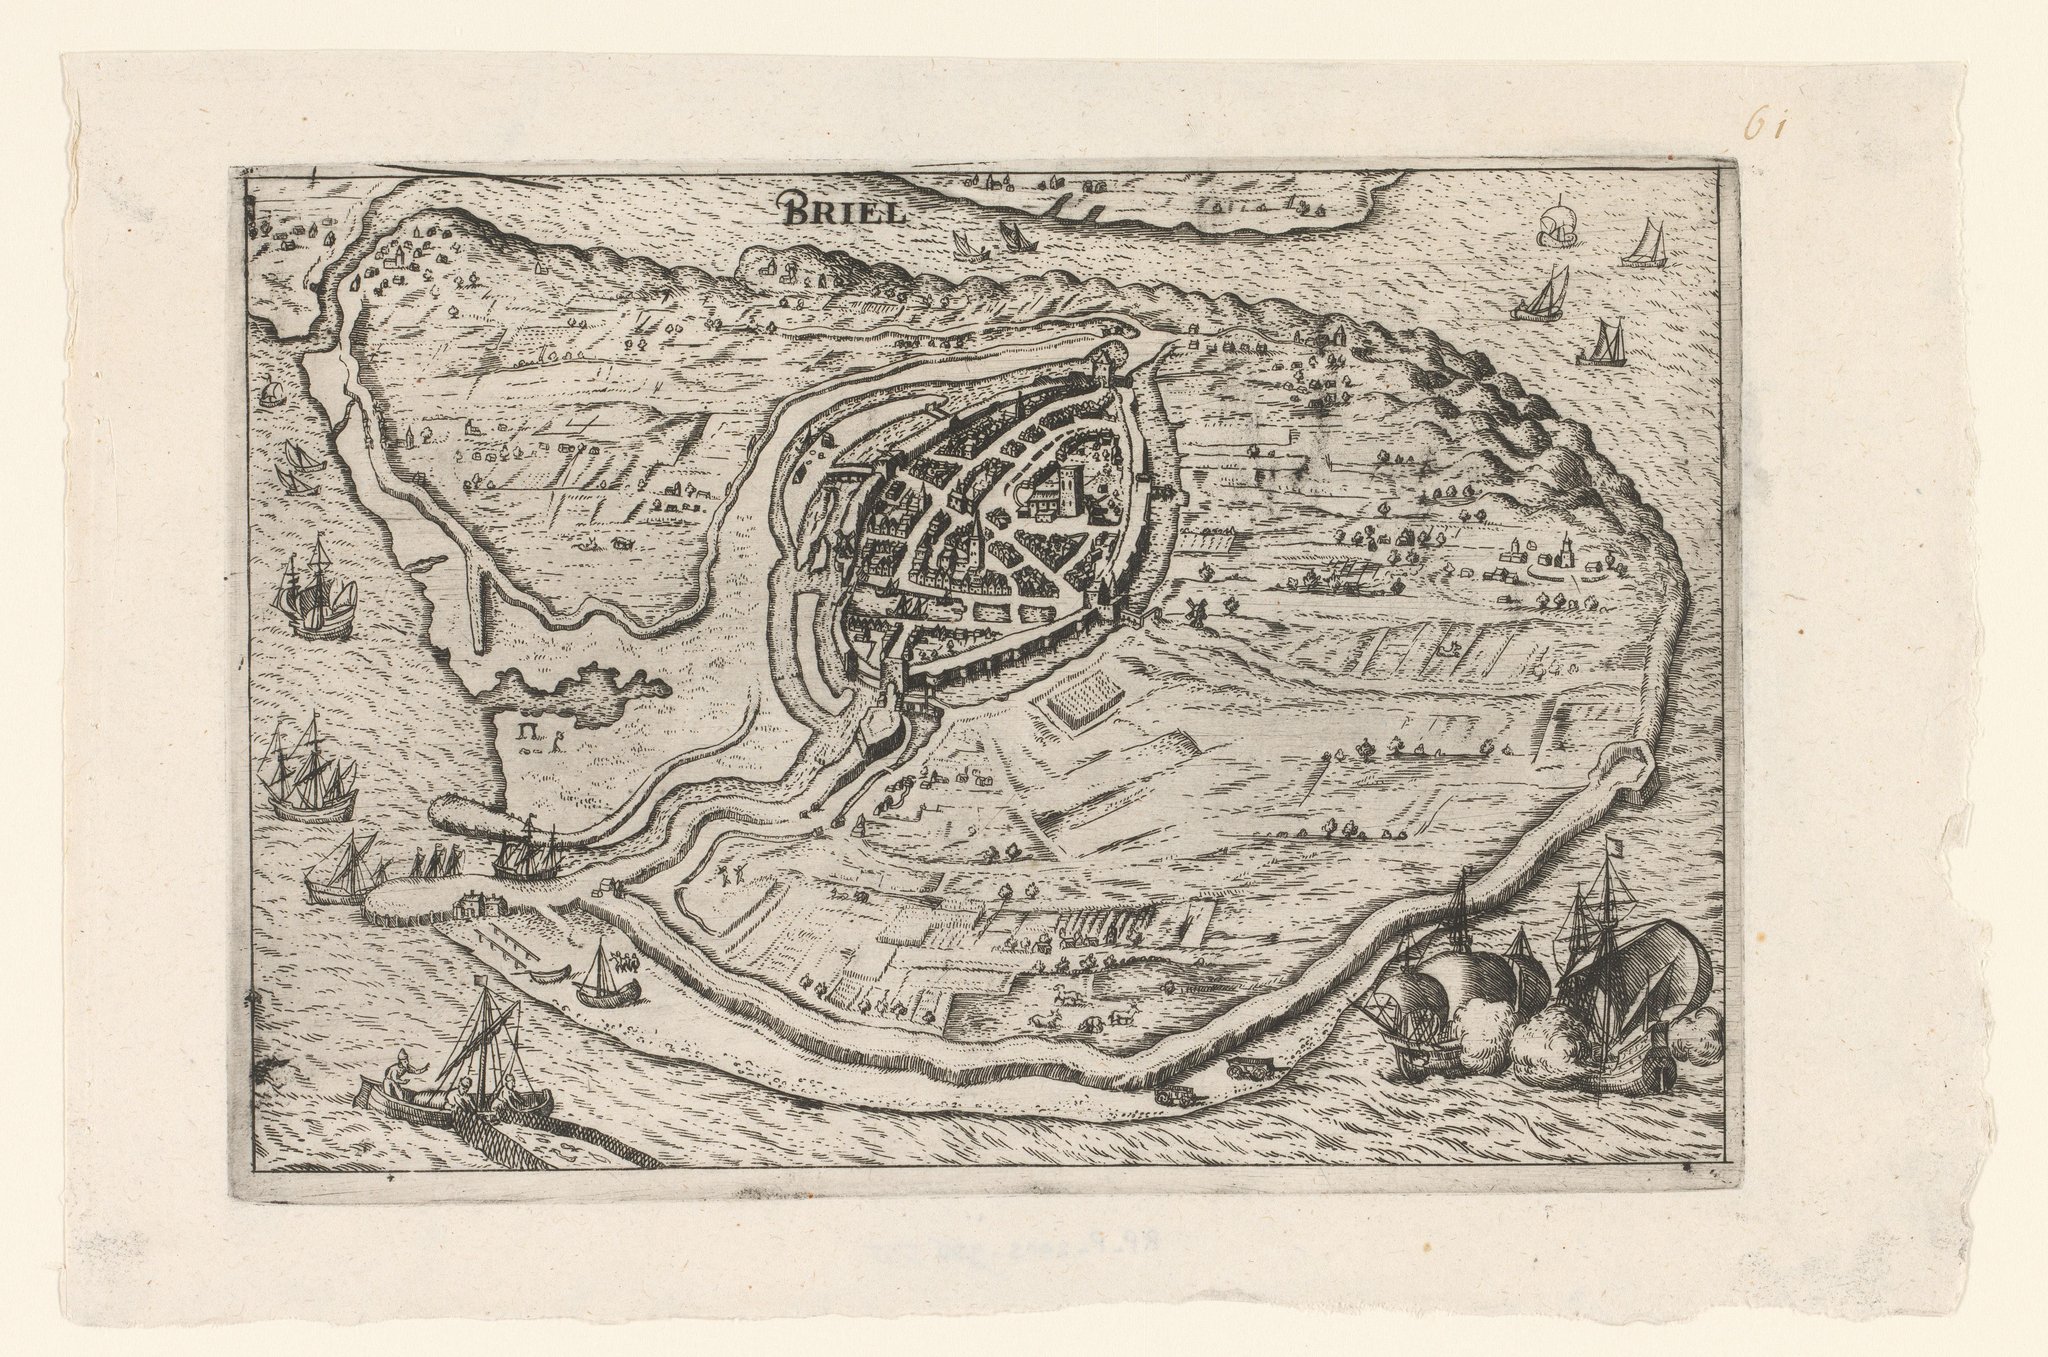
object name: print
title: Briel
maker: Anonymous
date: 1607-1609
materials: paper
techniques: etching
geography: southern netherlands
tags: maps of cities, brielle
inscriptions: number: ‘61’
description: Plattegrond van de stad Den Briel (Brielle) en omgeving. Rechtsonder een gevecht tussen twee schepen op zee. Onderdeel van de verzameling kaarten genomen uit een latere editie van: Descrittione di tutti i Paesi Bassi van Lodovico Guicciardini.